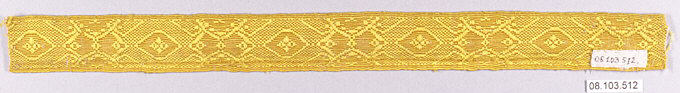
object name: galloon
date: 1701-1800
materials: cotton, silk